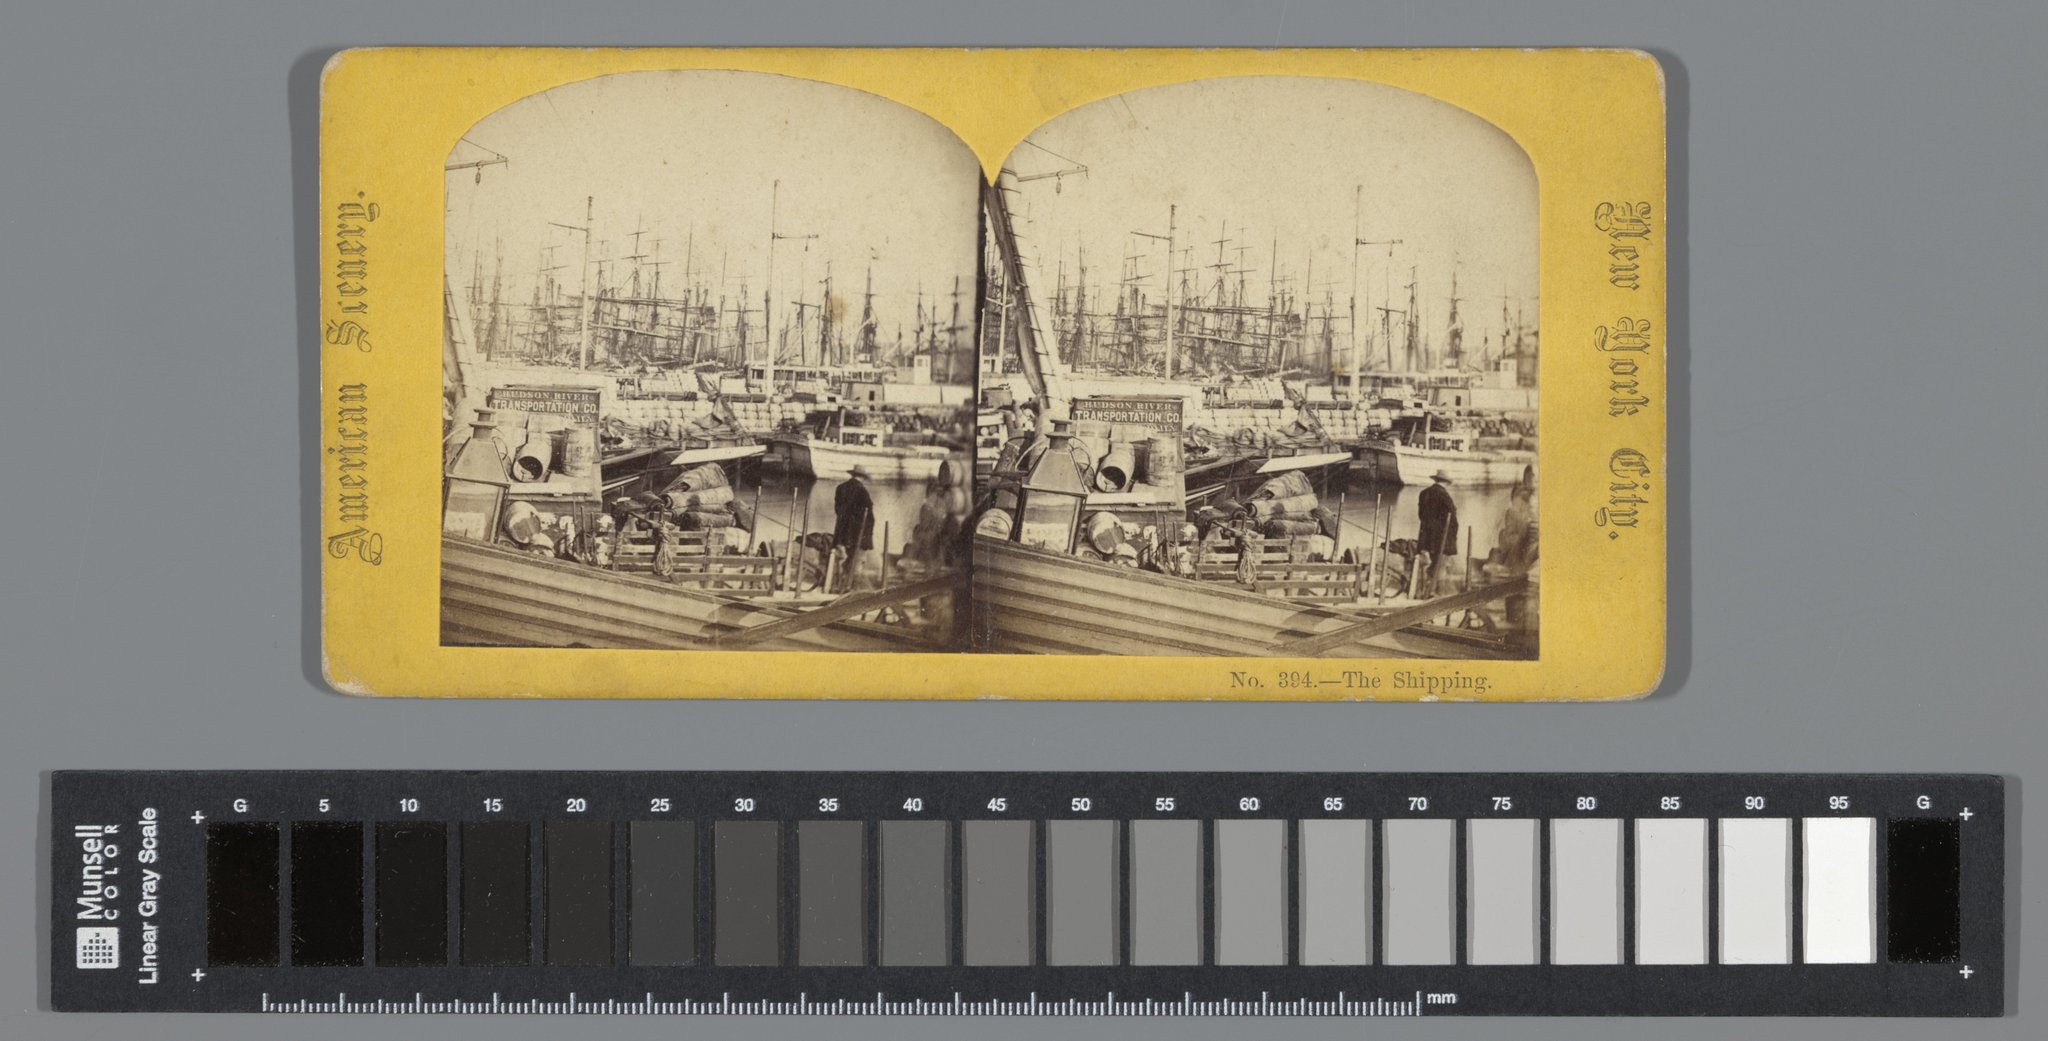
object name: stereograph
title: The Shipping in New York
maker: Anonymous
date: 1860-1865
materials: cardboard, paper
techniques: albumen print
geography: new york city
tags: harbour, ships (in general), harbour equipment, new york (city)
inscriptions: number: ‘No. 394’